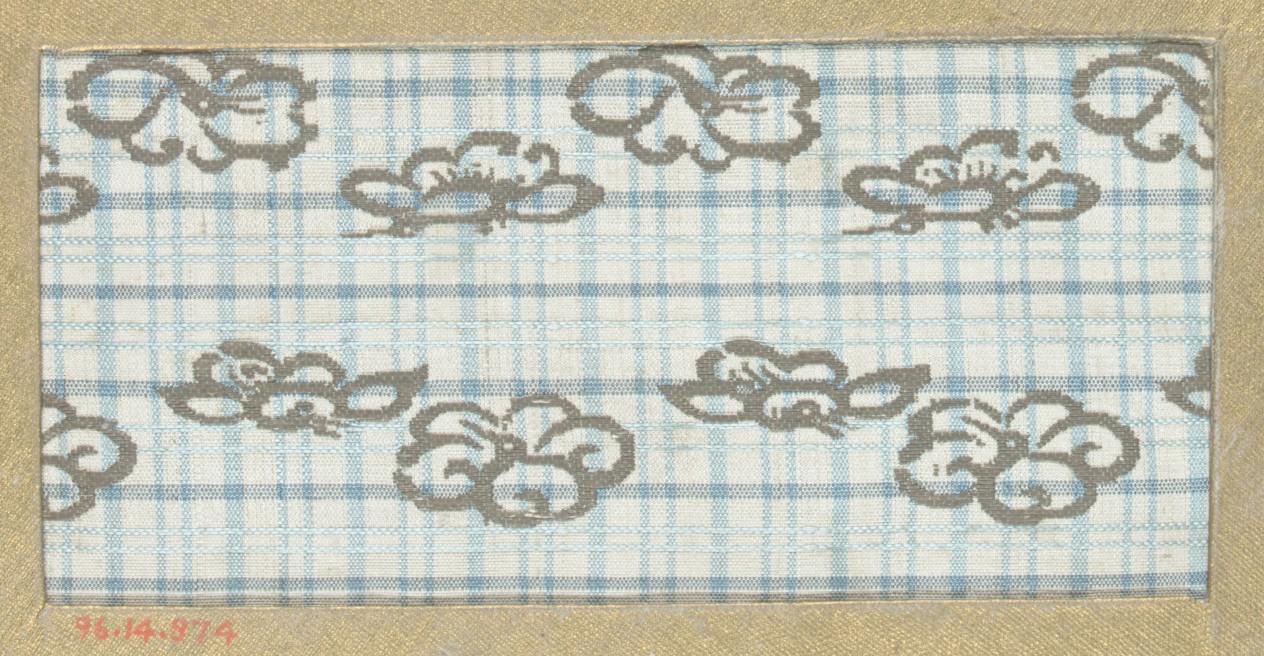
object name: piece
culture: japanese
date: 1701-1900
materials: silk